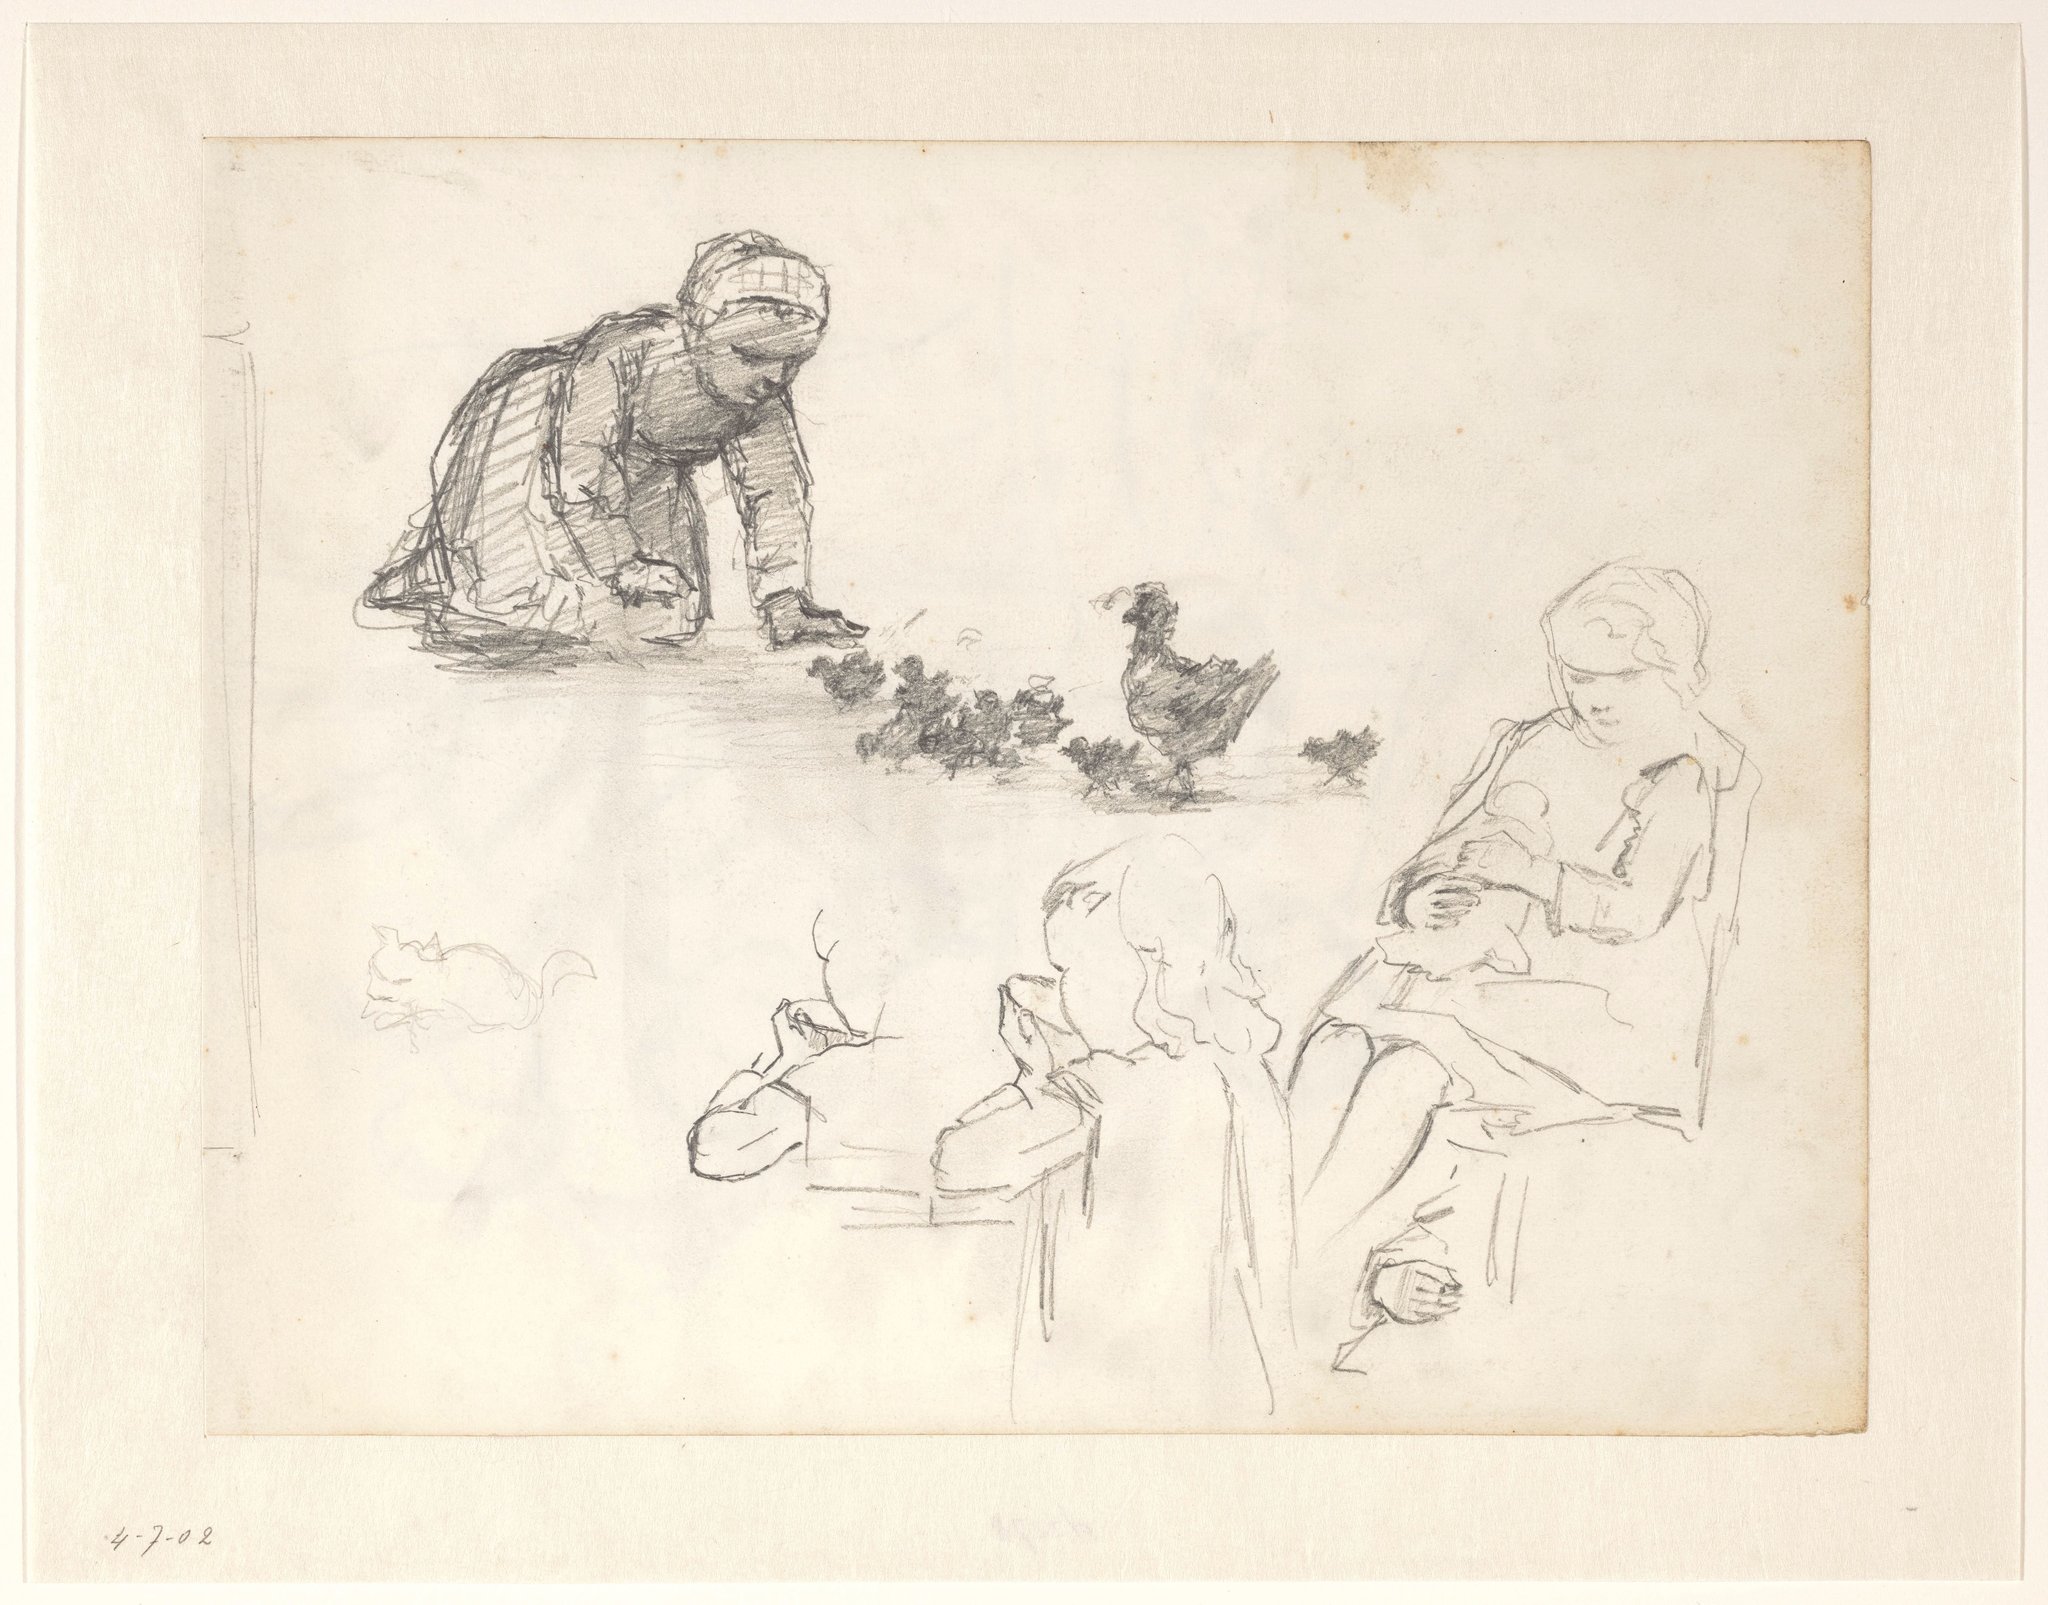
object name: drawing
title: Drie voorstellingen van een meisje met kuikens, een kom, en een pop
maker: hendrik valkenburg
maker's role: draughtsman, painter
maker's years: 1826-1896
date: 1836-1896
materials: paper, pencil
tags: child, interior of the house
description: Meisje met kuikens, meisje drinkend uit een kom en een meisje met een pop. Verso: kinderen aan tafel.